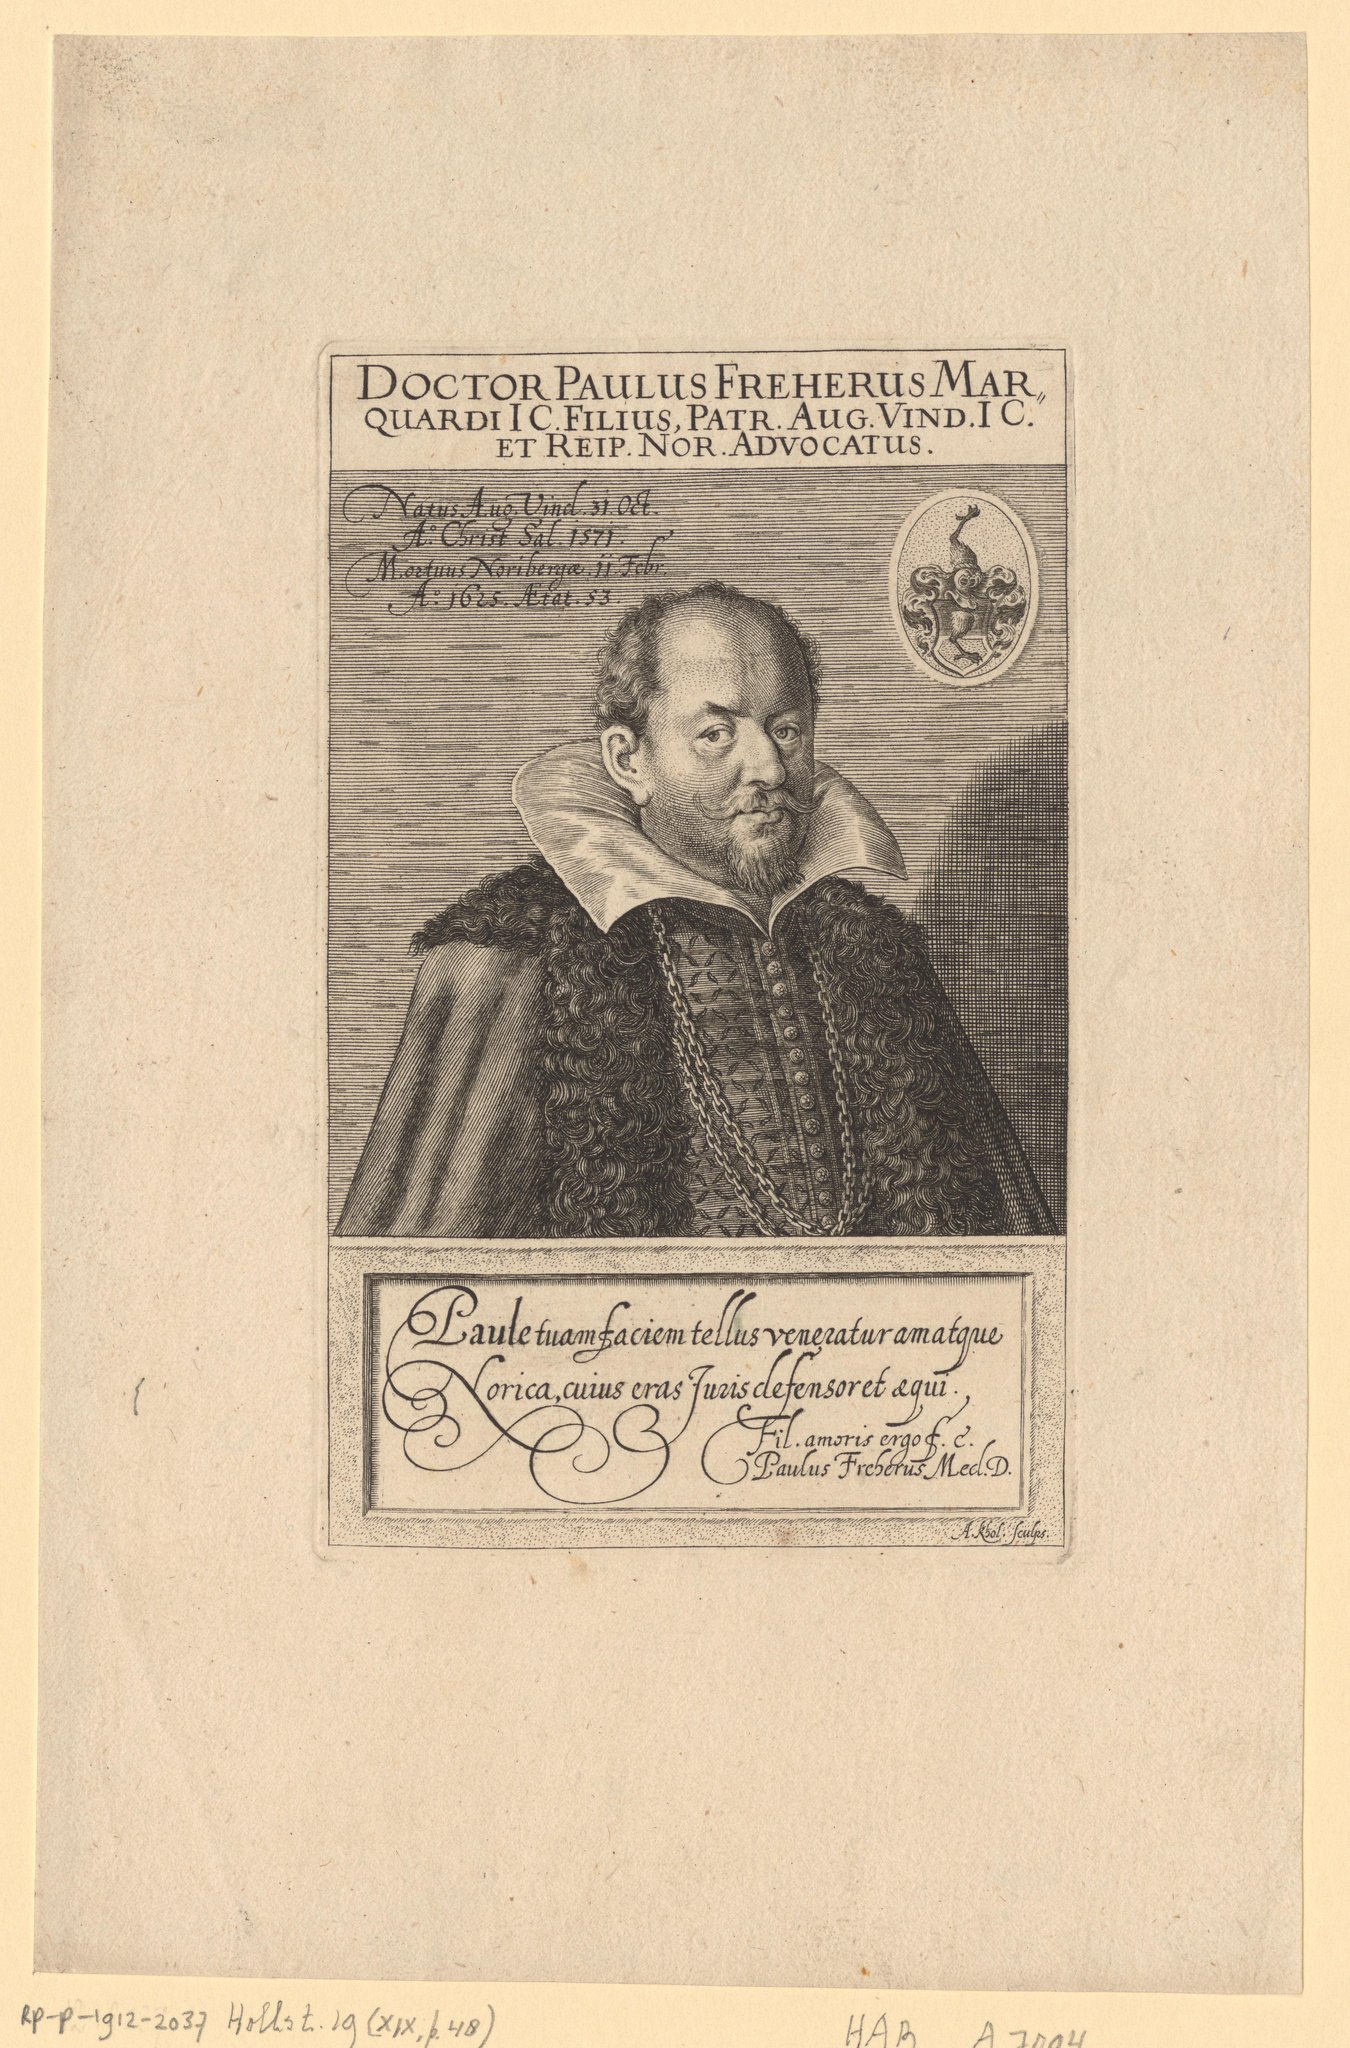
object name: print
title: Portret van Paul Freher I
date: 1625-1657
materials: paper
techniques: engraving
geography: germany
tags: augsburg, paul freher (i), historical persons, lawyer, attorney at law, armorial bearing, heraldry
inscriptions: collector's mark: Lugt 2228